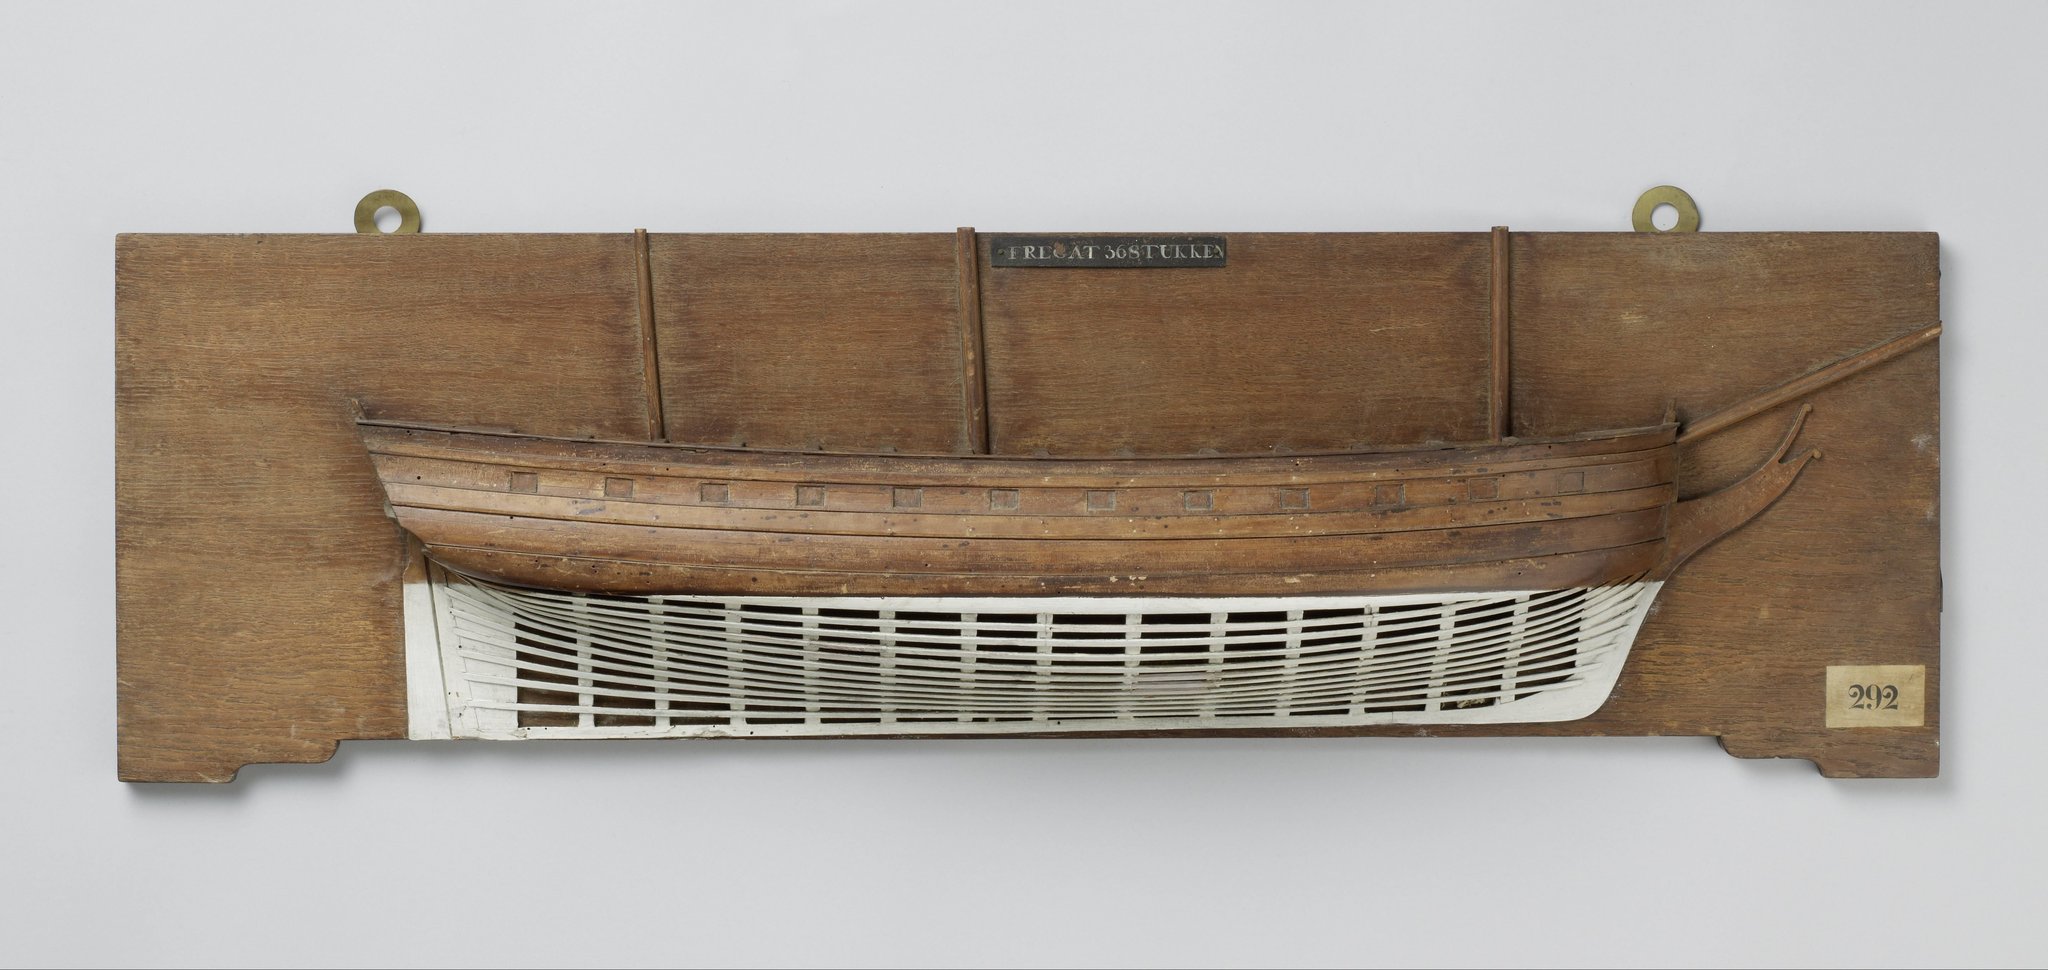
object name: half model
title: Half Model of a 36-Gun Frigate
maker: Anonymous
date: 1780-1825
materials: wood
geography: netherlands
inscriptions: label, bottom right: ‘292’ former inventory label, inscription, top centre, on a square black metal label: ‘FREGAT 36 STUKKEN’